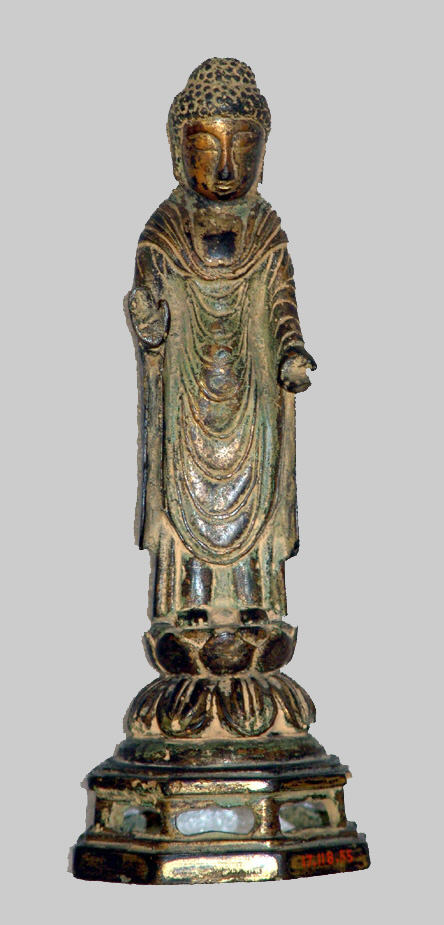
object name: statuette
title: Standing Buddha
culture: korean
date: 668-935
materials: gilt bronze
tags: buddhism,buddha